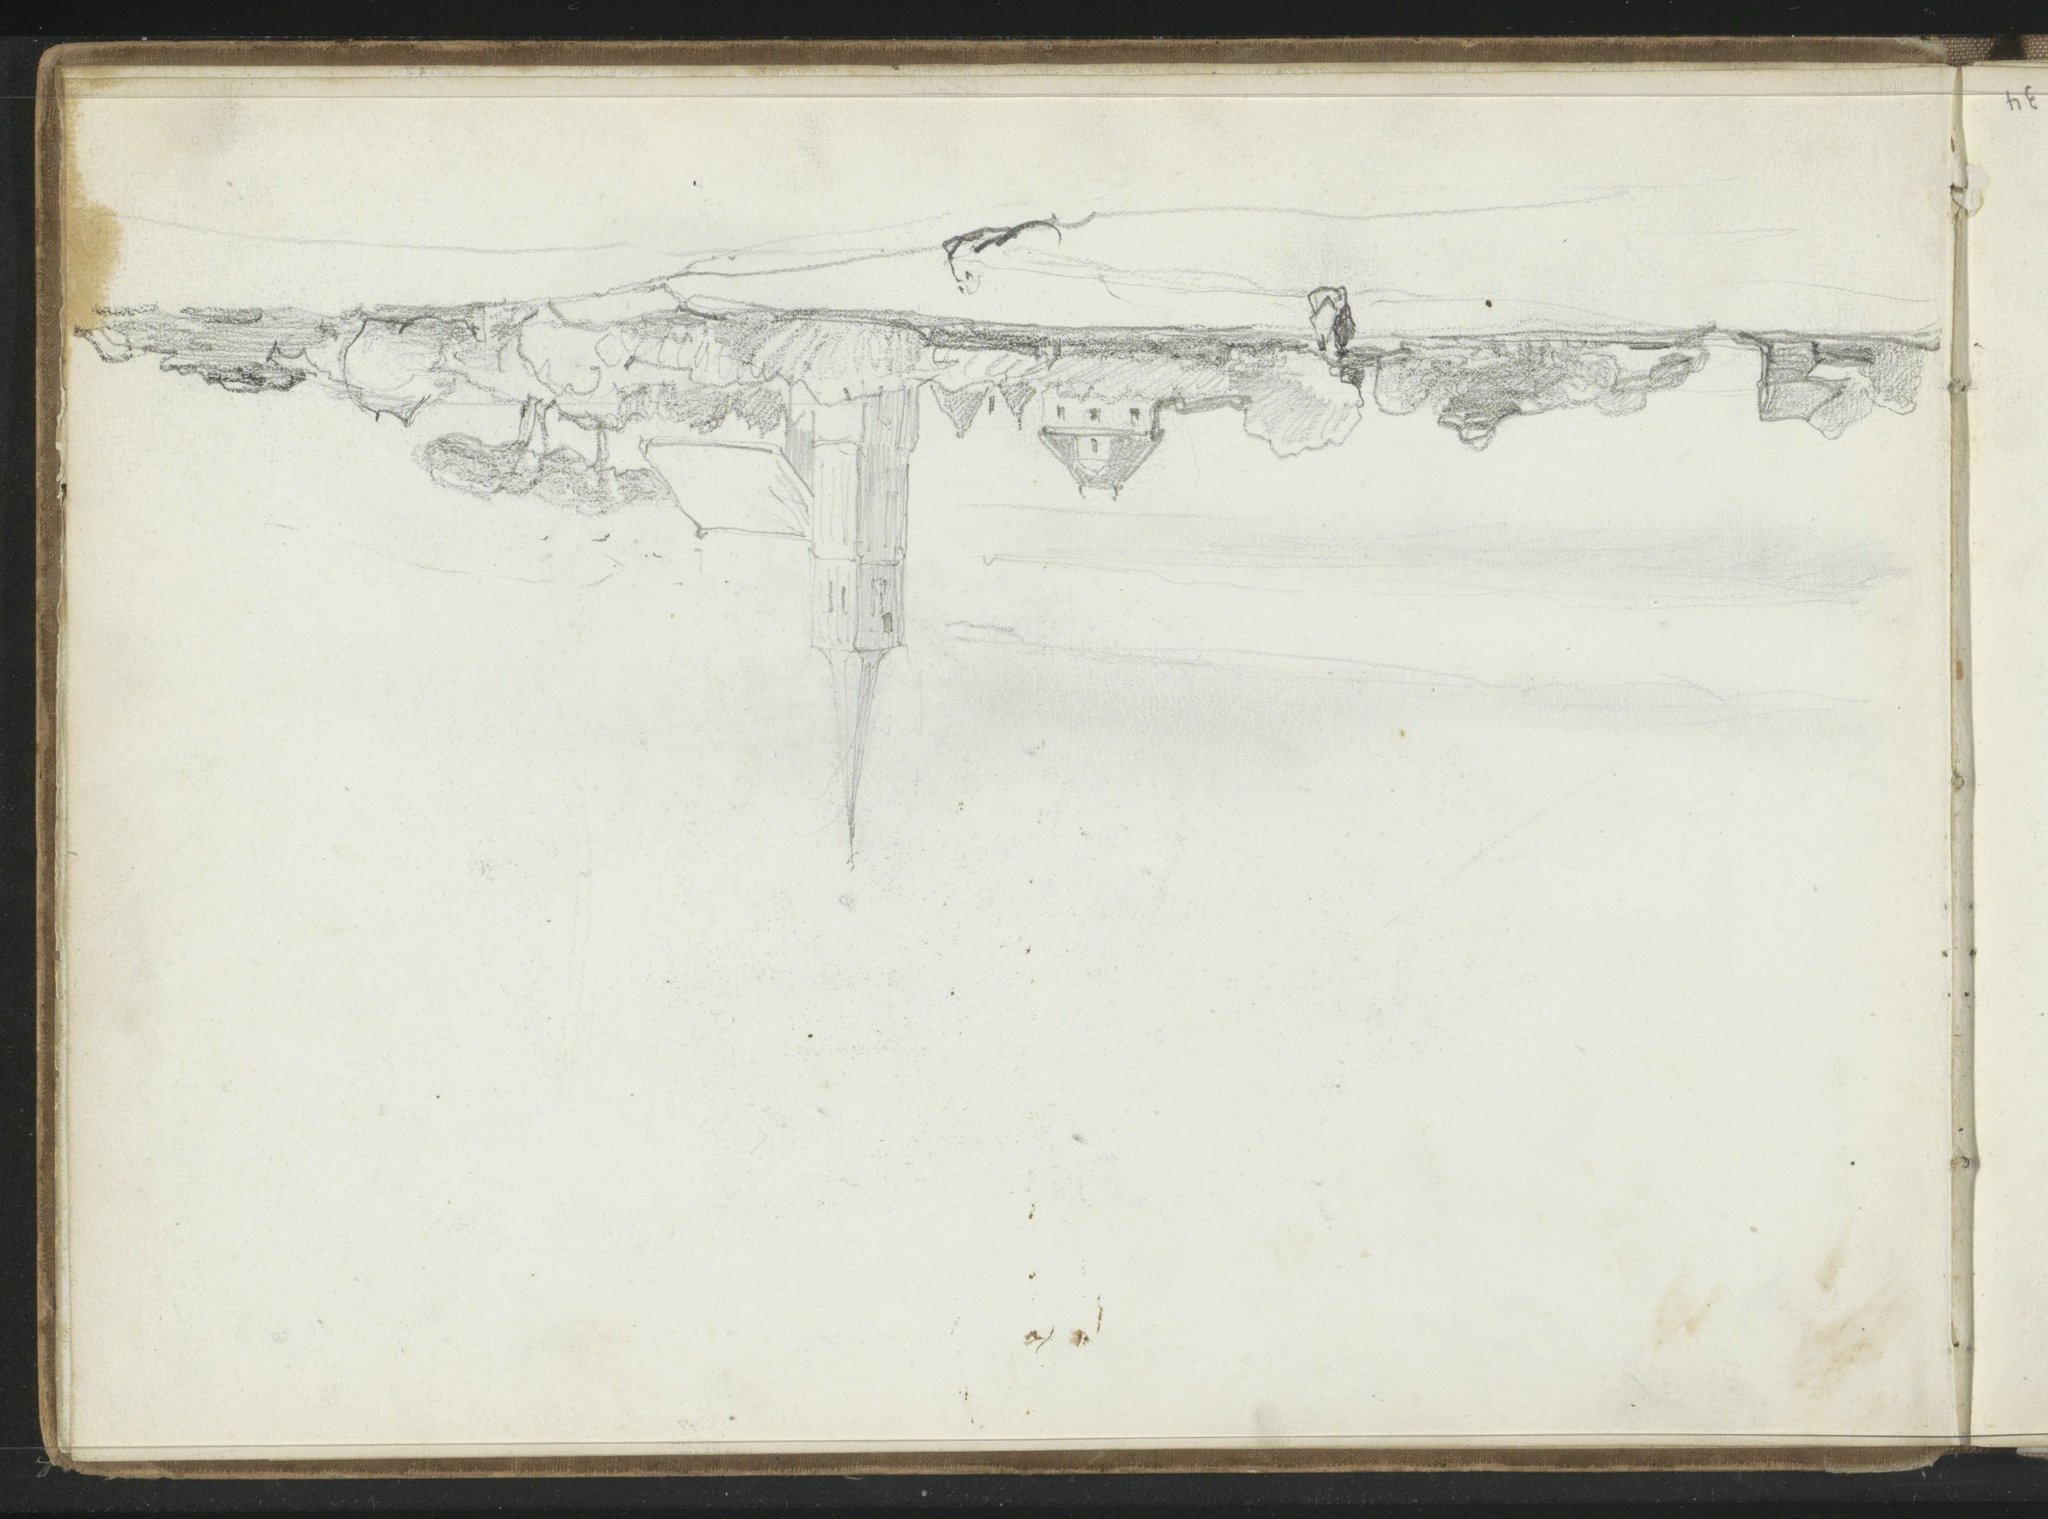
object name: sketchbook leaf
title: Gezicht op de kerk en pastorie van Sijbekarspel (gezien vanuit het westen)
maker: johannes bosboom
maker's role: draughtsman, painter, print maker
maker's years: 1817-1891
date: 1827-1891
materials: paper, pencil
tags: prospect of village, silhouette of village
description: Blad 2 verso uit een schetsboek met 41 pagina's.